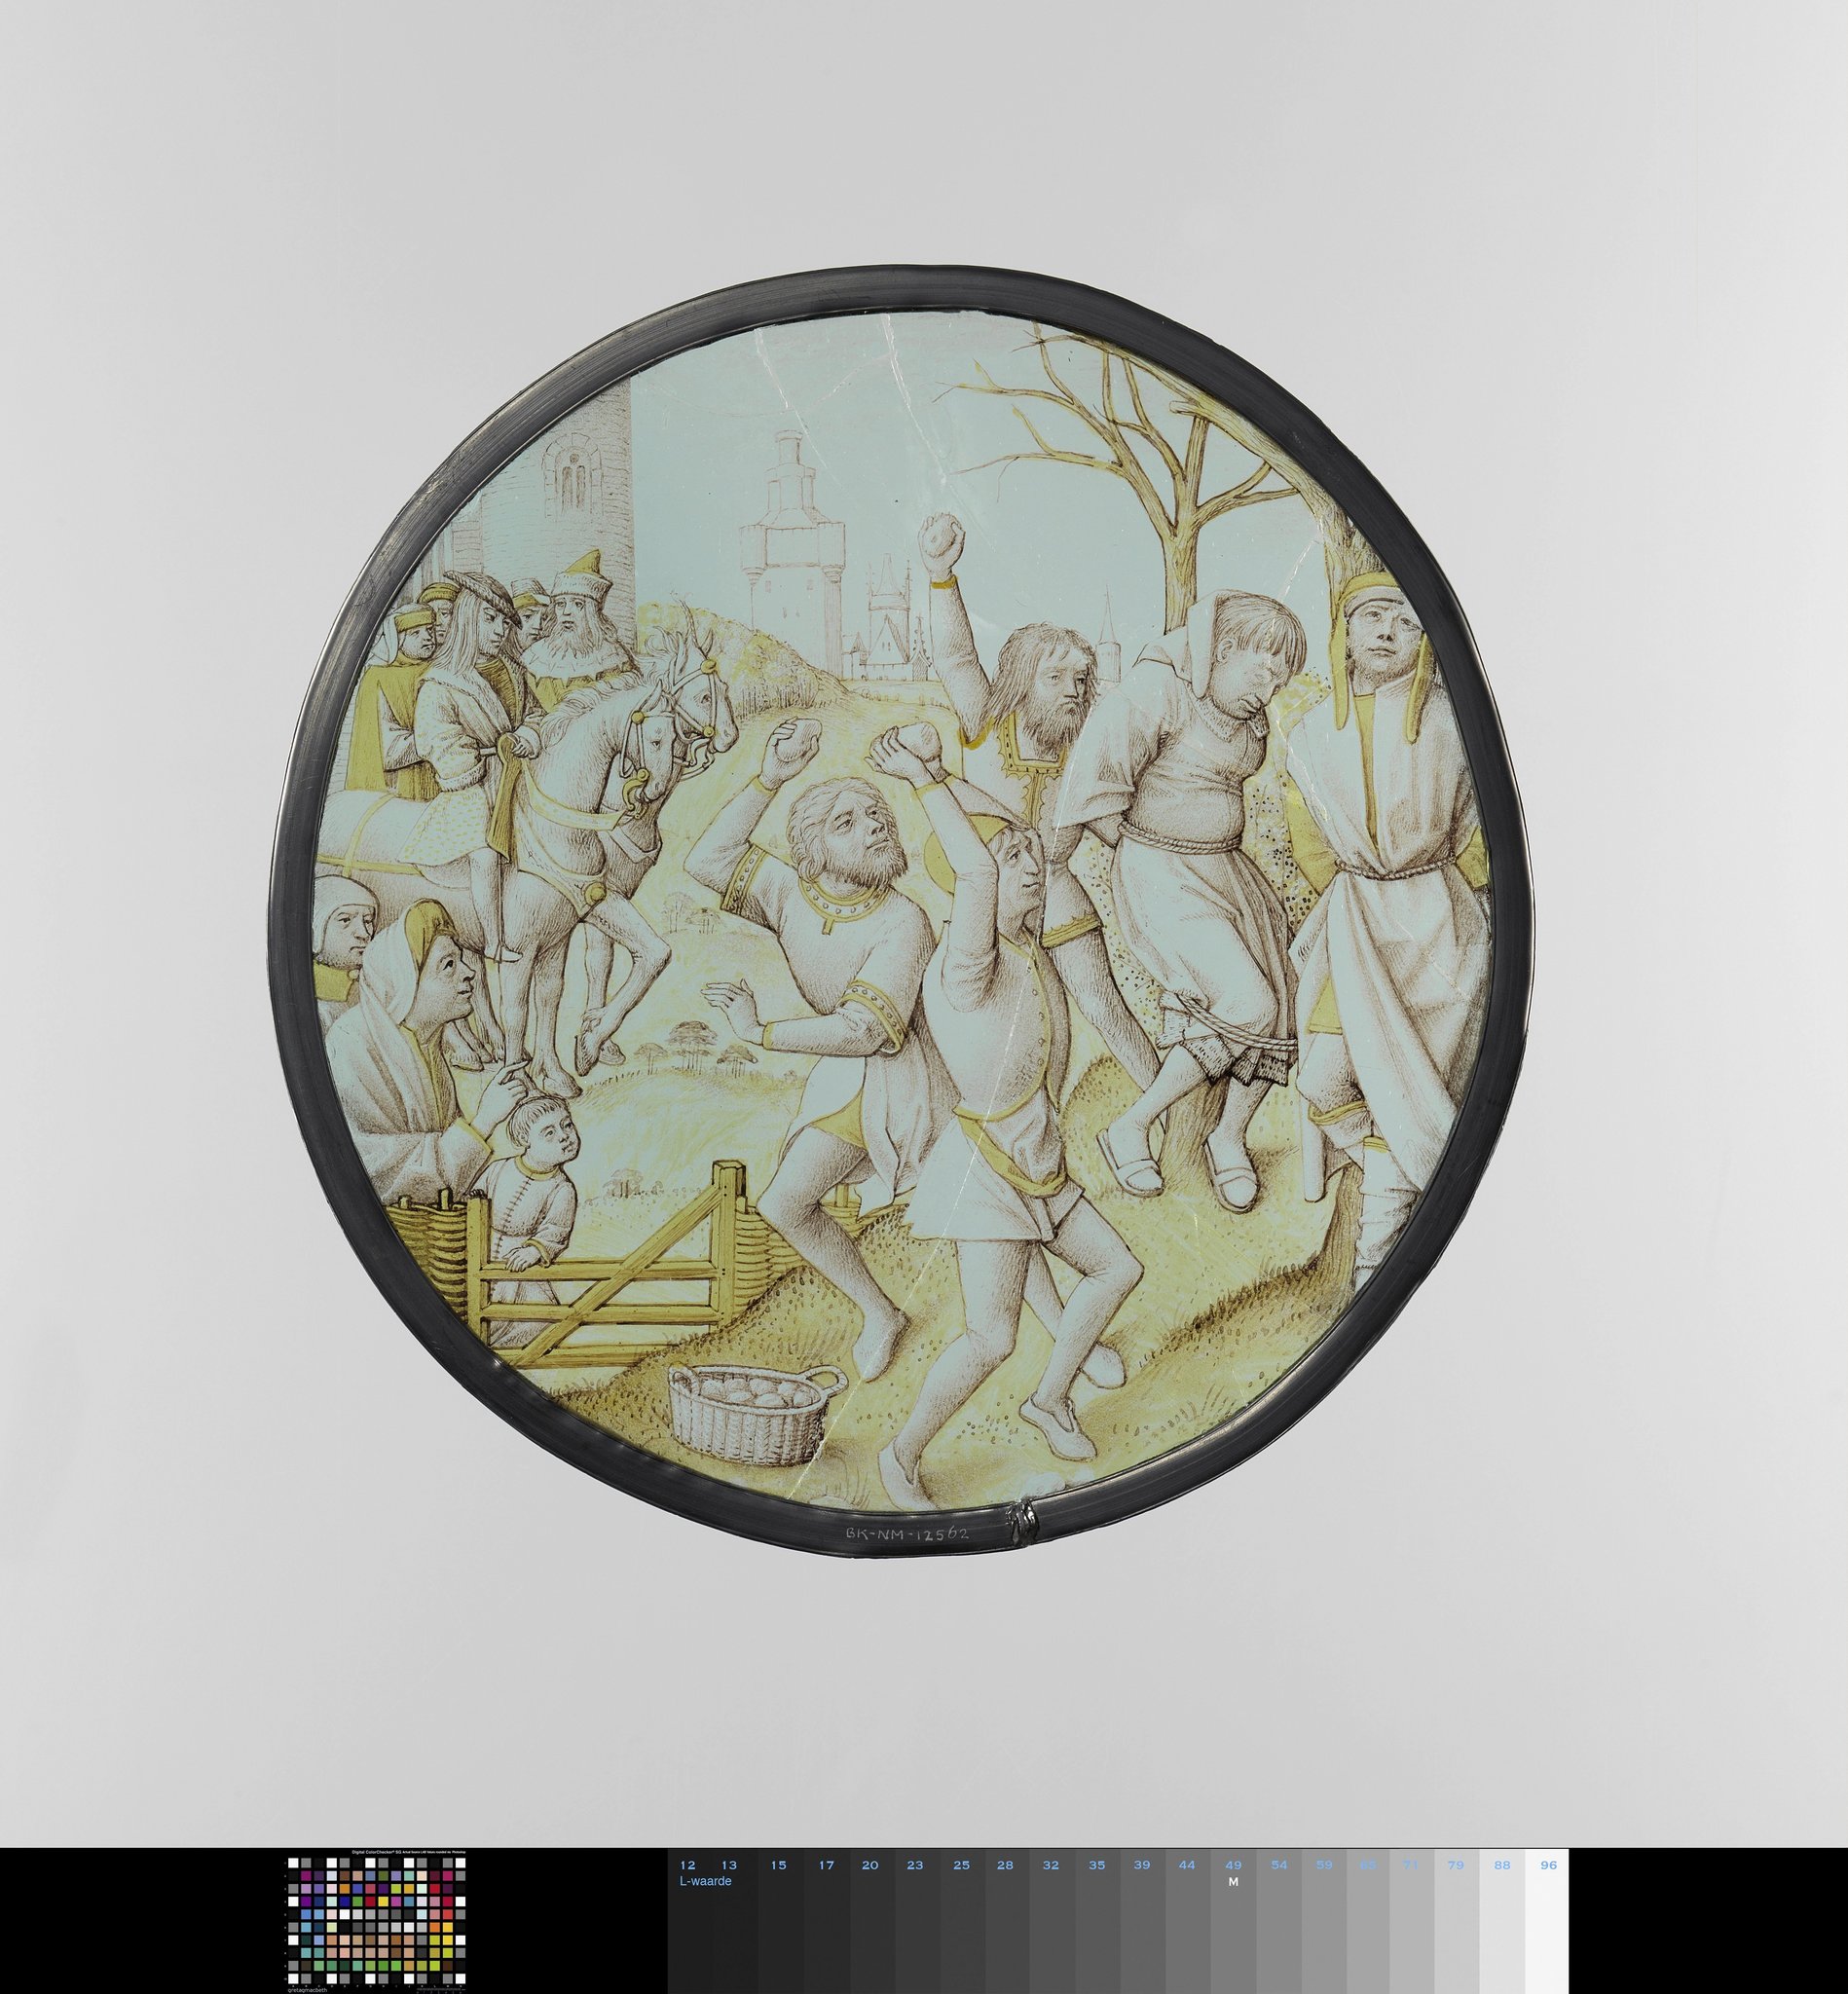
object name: light window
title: Ruit met het stenigen van de grijsaards uit de geschiedenis van Susanna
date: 1490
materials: glass, lead, pigment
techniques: leading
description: The Stoning of an Old Men. Stained glass. Netherlands, c. 1500.